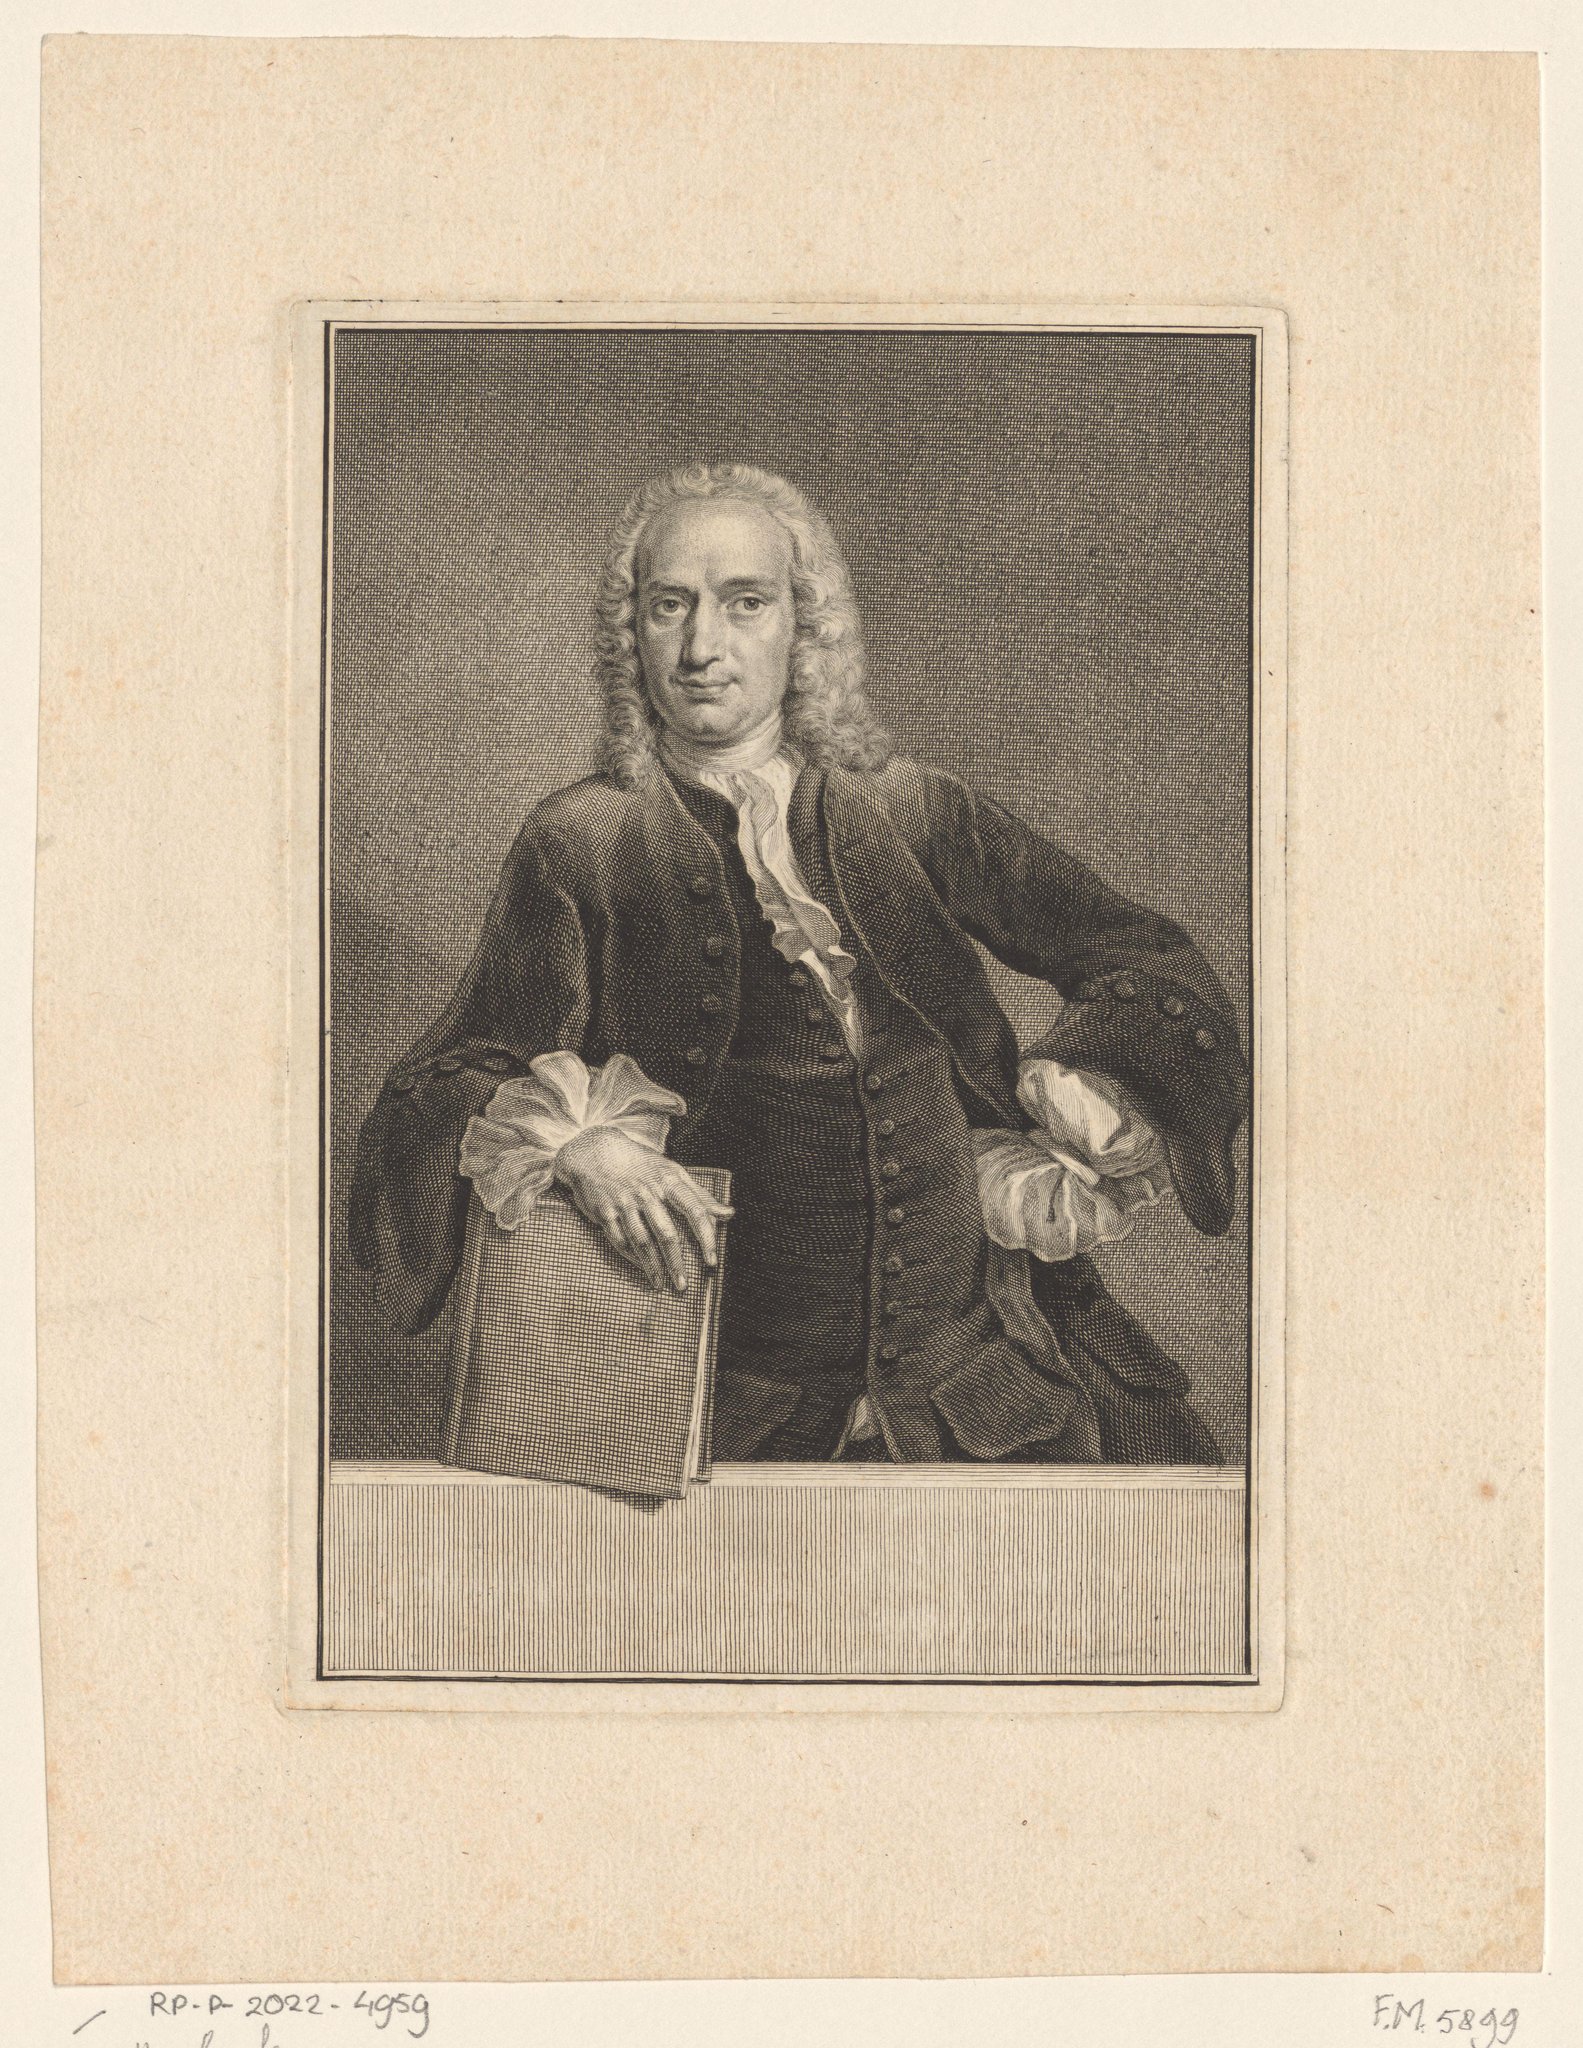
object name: print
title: Portret van Hubertus Gregorius van Vrijhoff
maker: jacob houbraken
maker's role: draughtsman, print maker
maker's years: 1698-1780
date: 1754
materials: paper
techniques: engraving, etching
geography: amsterdam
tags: scholar, philosopher, historical persons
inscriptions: number: ‘*12-’, collector's mark: Lugt 2228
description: Latere staat gebruikt in: Vrijhoff, Hubert Gregorius van. De gedigten van H.G. van Vryhoff. Amsterdam: Jan Roman (II), 1755.